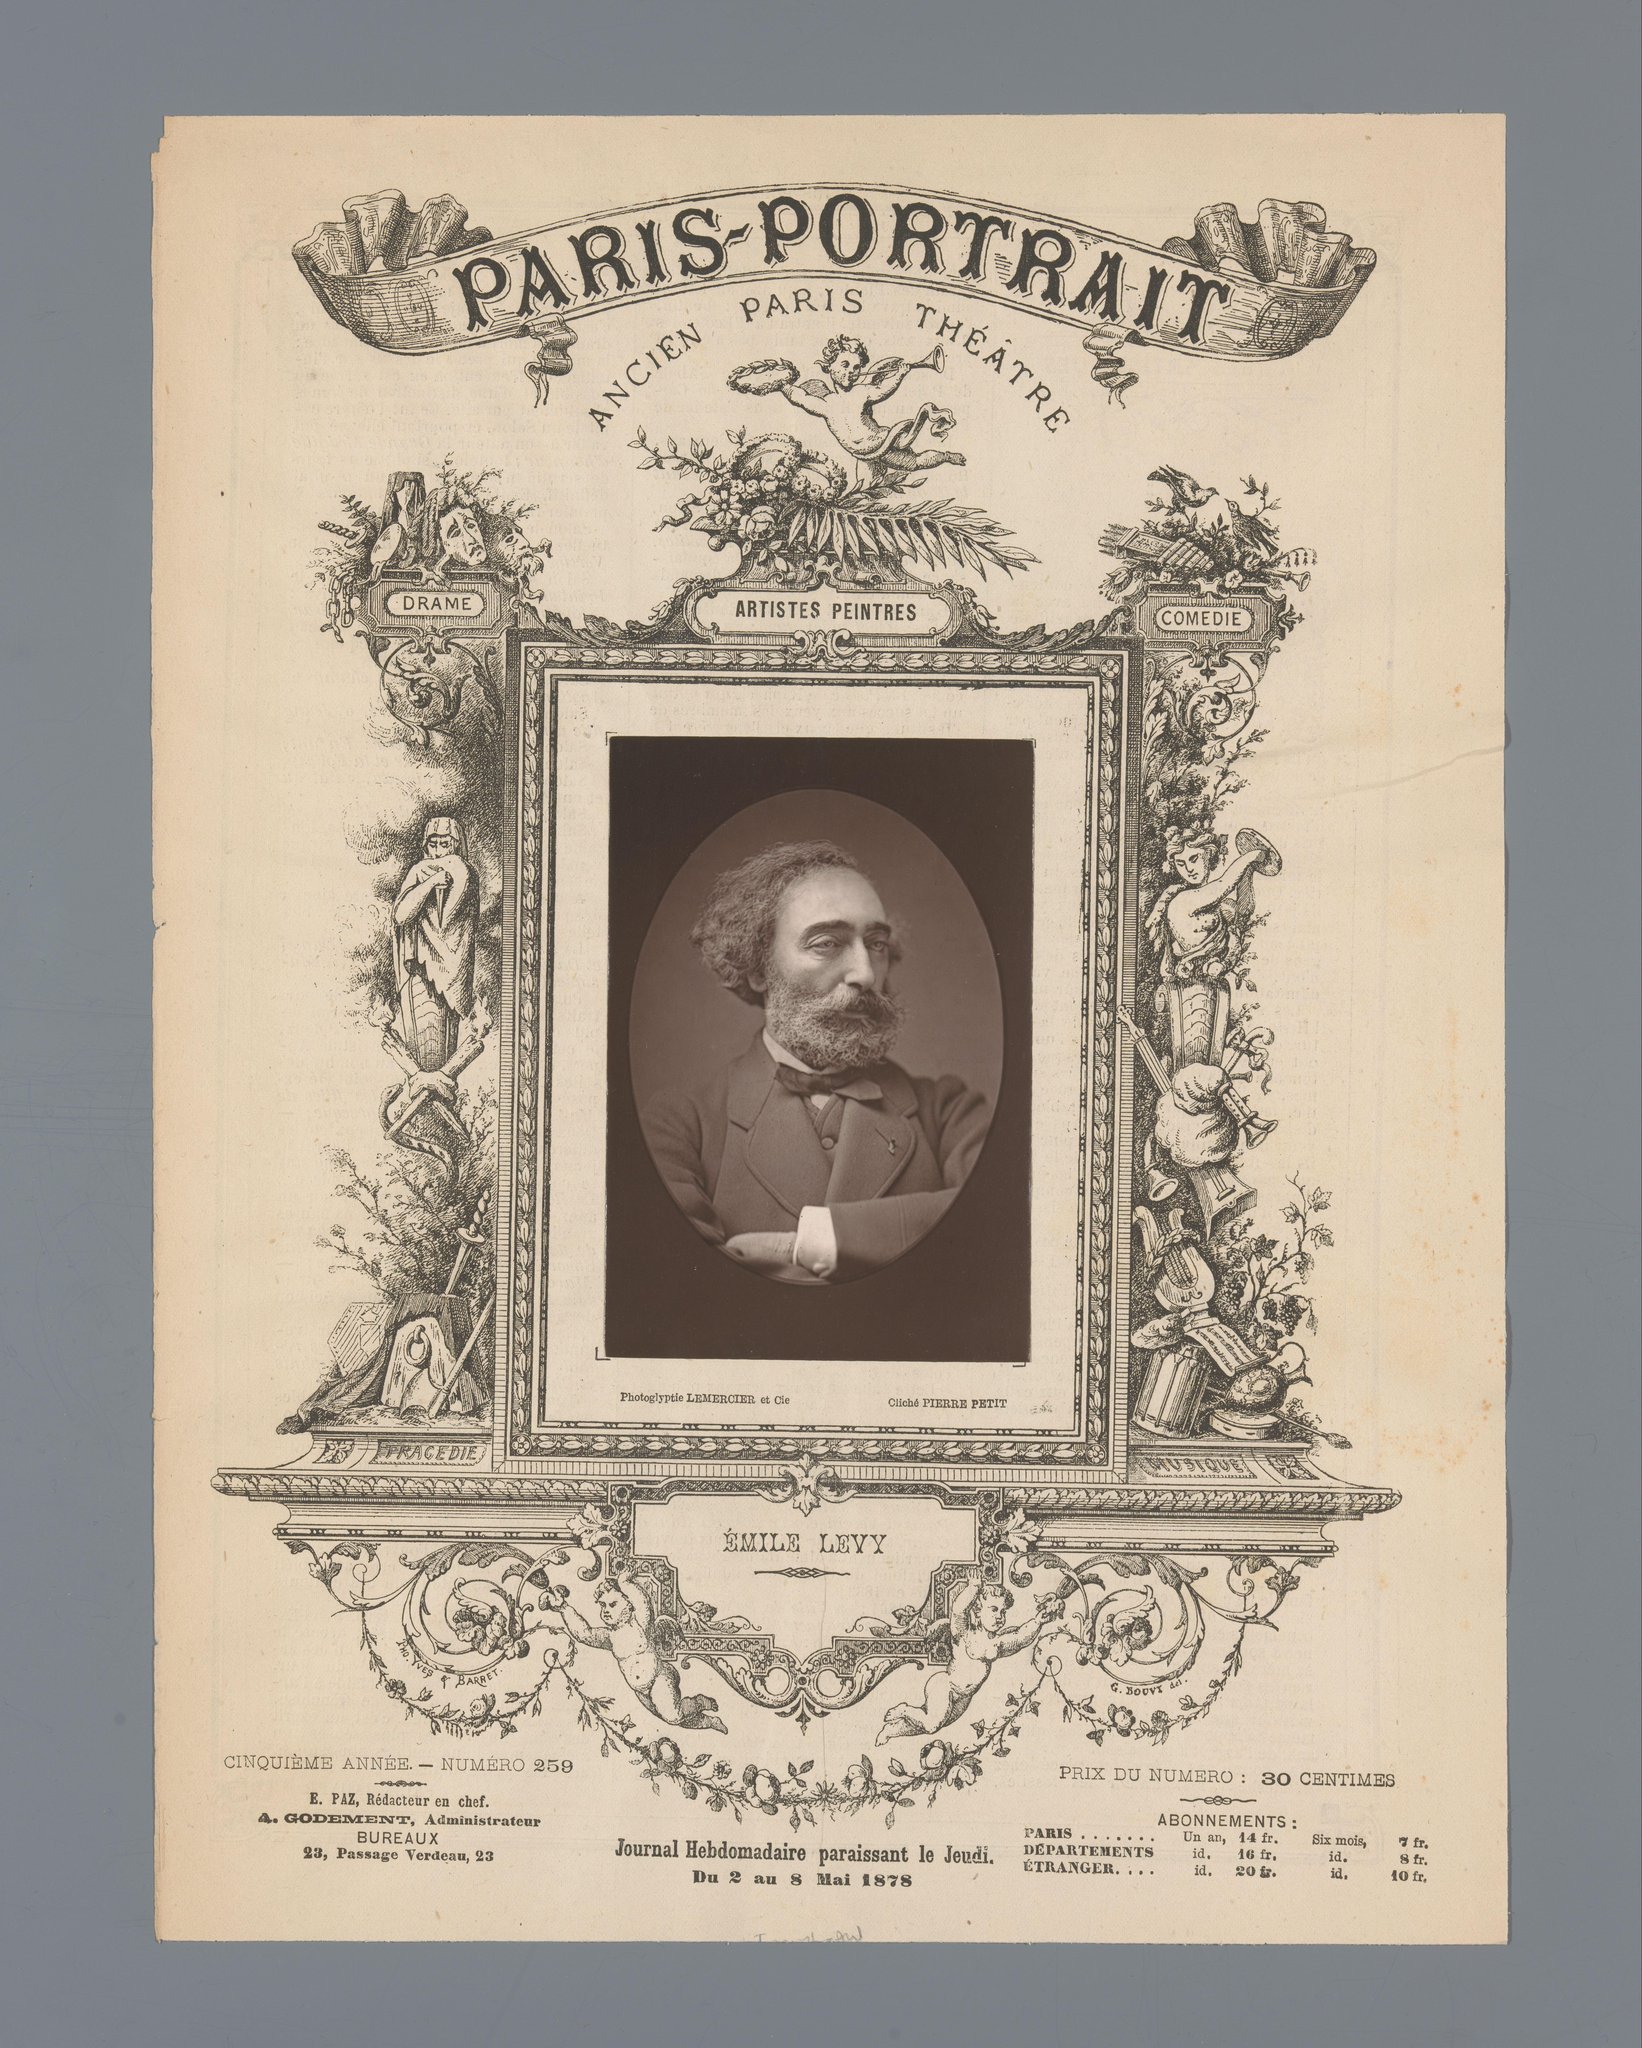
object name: photomechanical print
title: Portret van Emile Lévy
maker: pierre petit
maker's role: fotograaf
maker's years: 1832-1909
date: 1872-1879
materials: paper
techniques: woodburytype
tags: paris, painter, emile lévy, historical persons